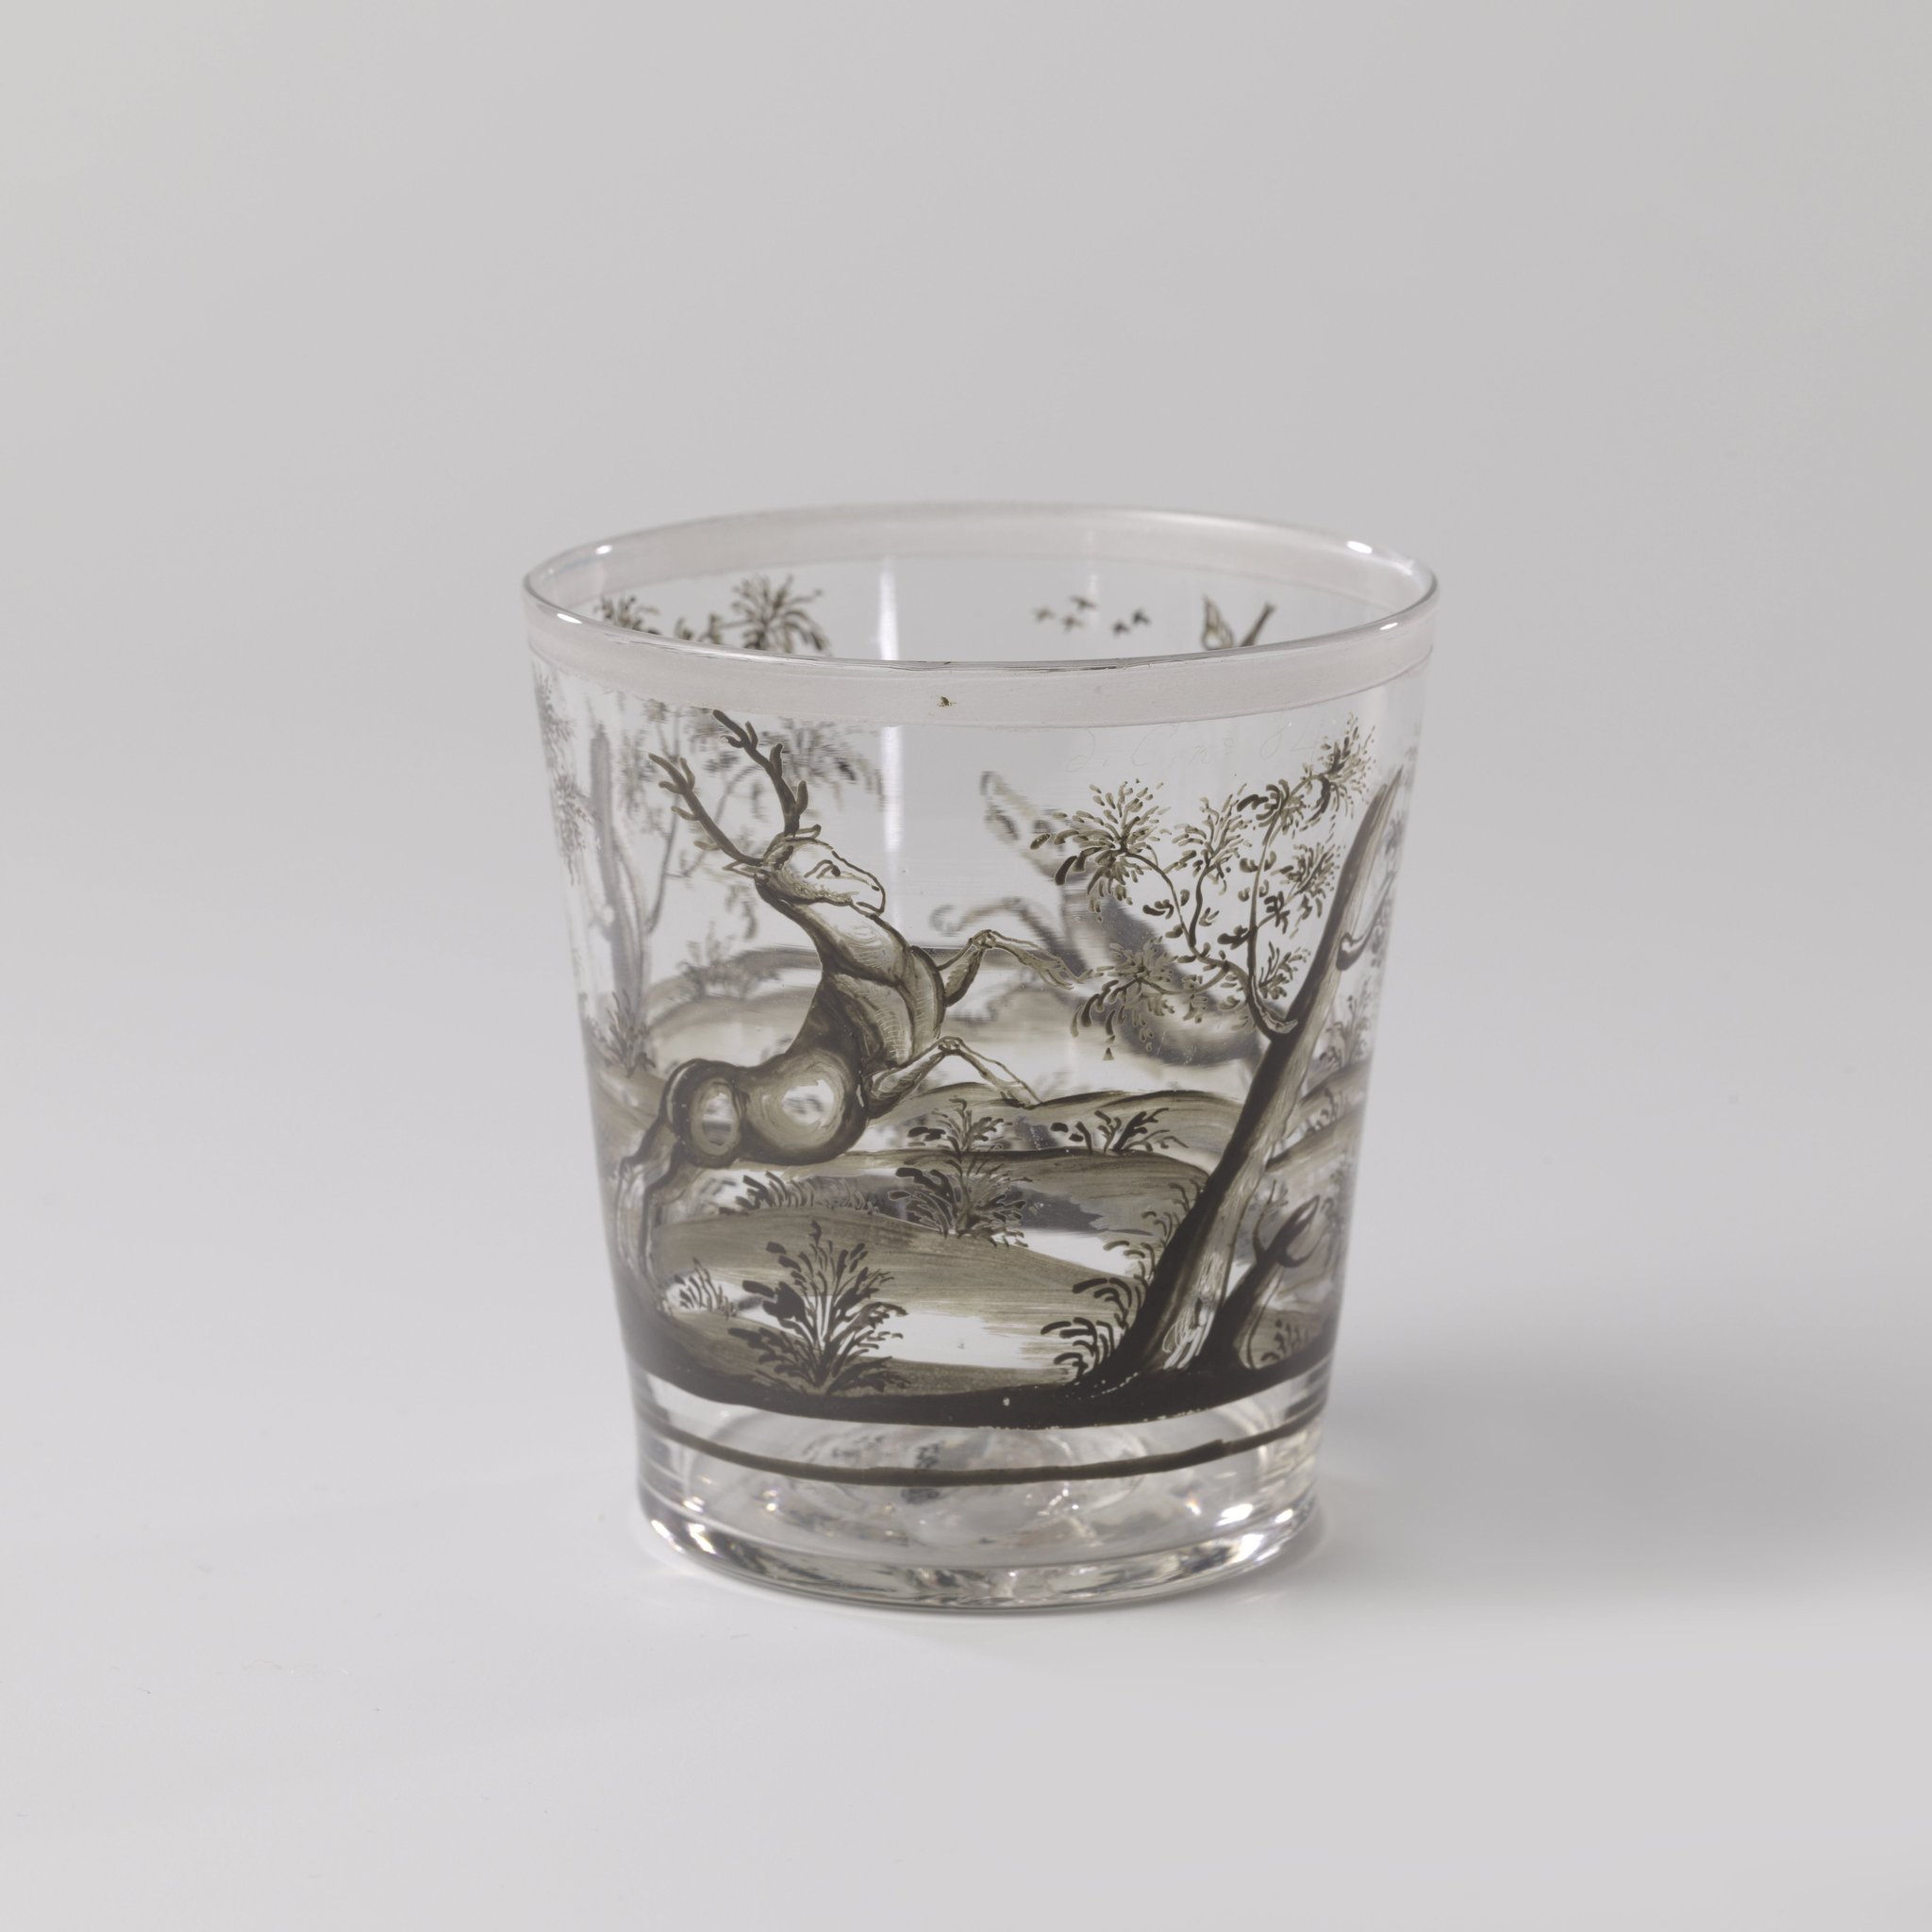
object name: cup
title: Beker met beschildering in Schwarzlot, met een hertenjacht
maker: Anonymous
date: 1735-1765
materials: glass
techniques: glassblowing, grinding, schwarzlot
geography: nuremberg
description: Beaker. Decorated in 'Schwarzlot' with a stag and a hound. Nuremberg, c. 1733 - 1765. On loan from the Koninklijk Oudheidkundig Genootschap.